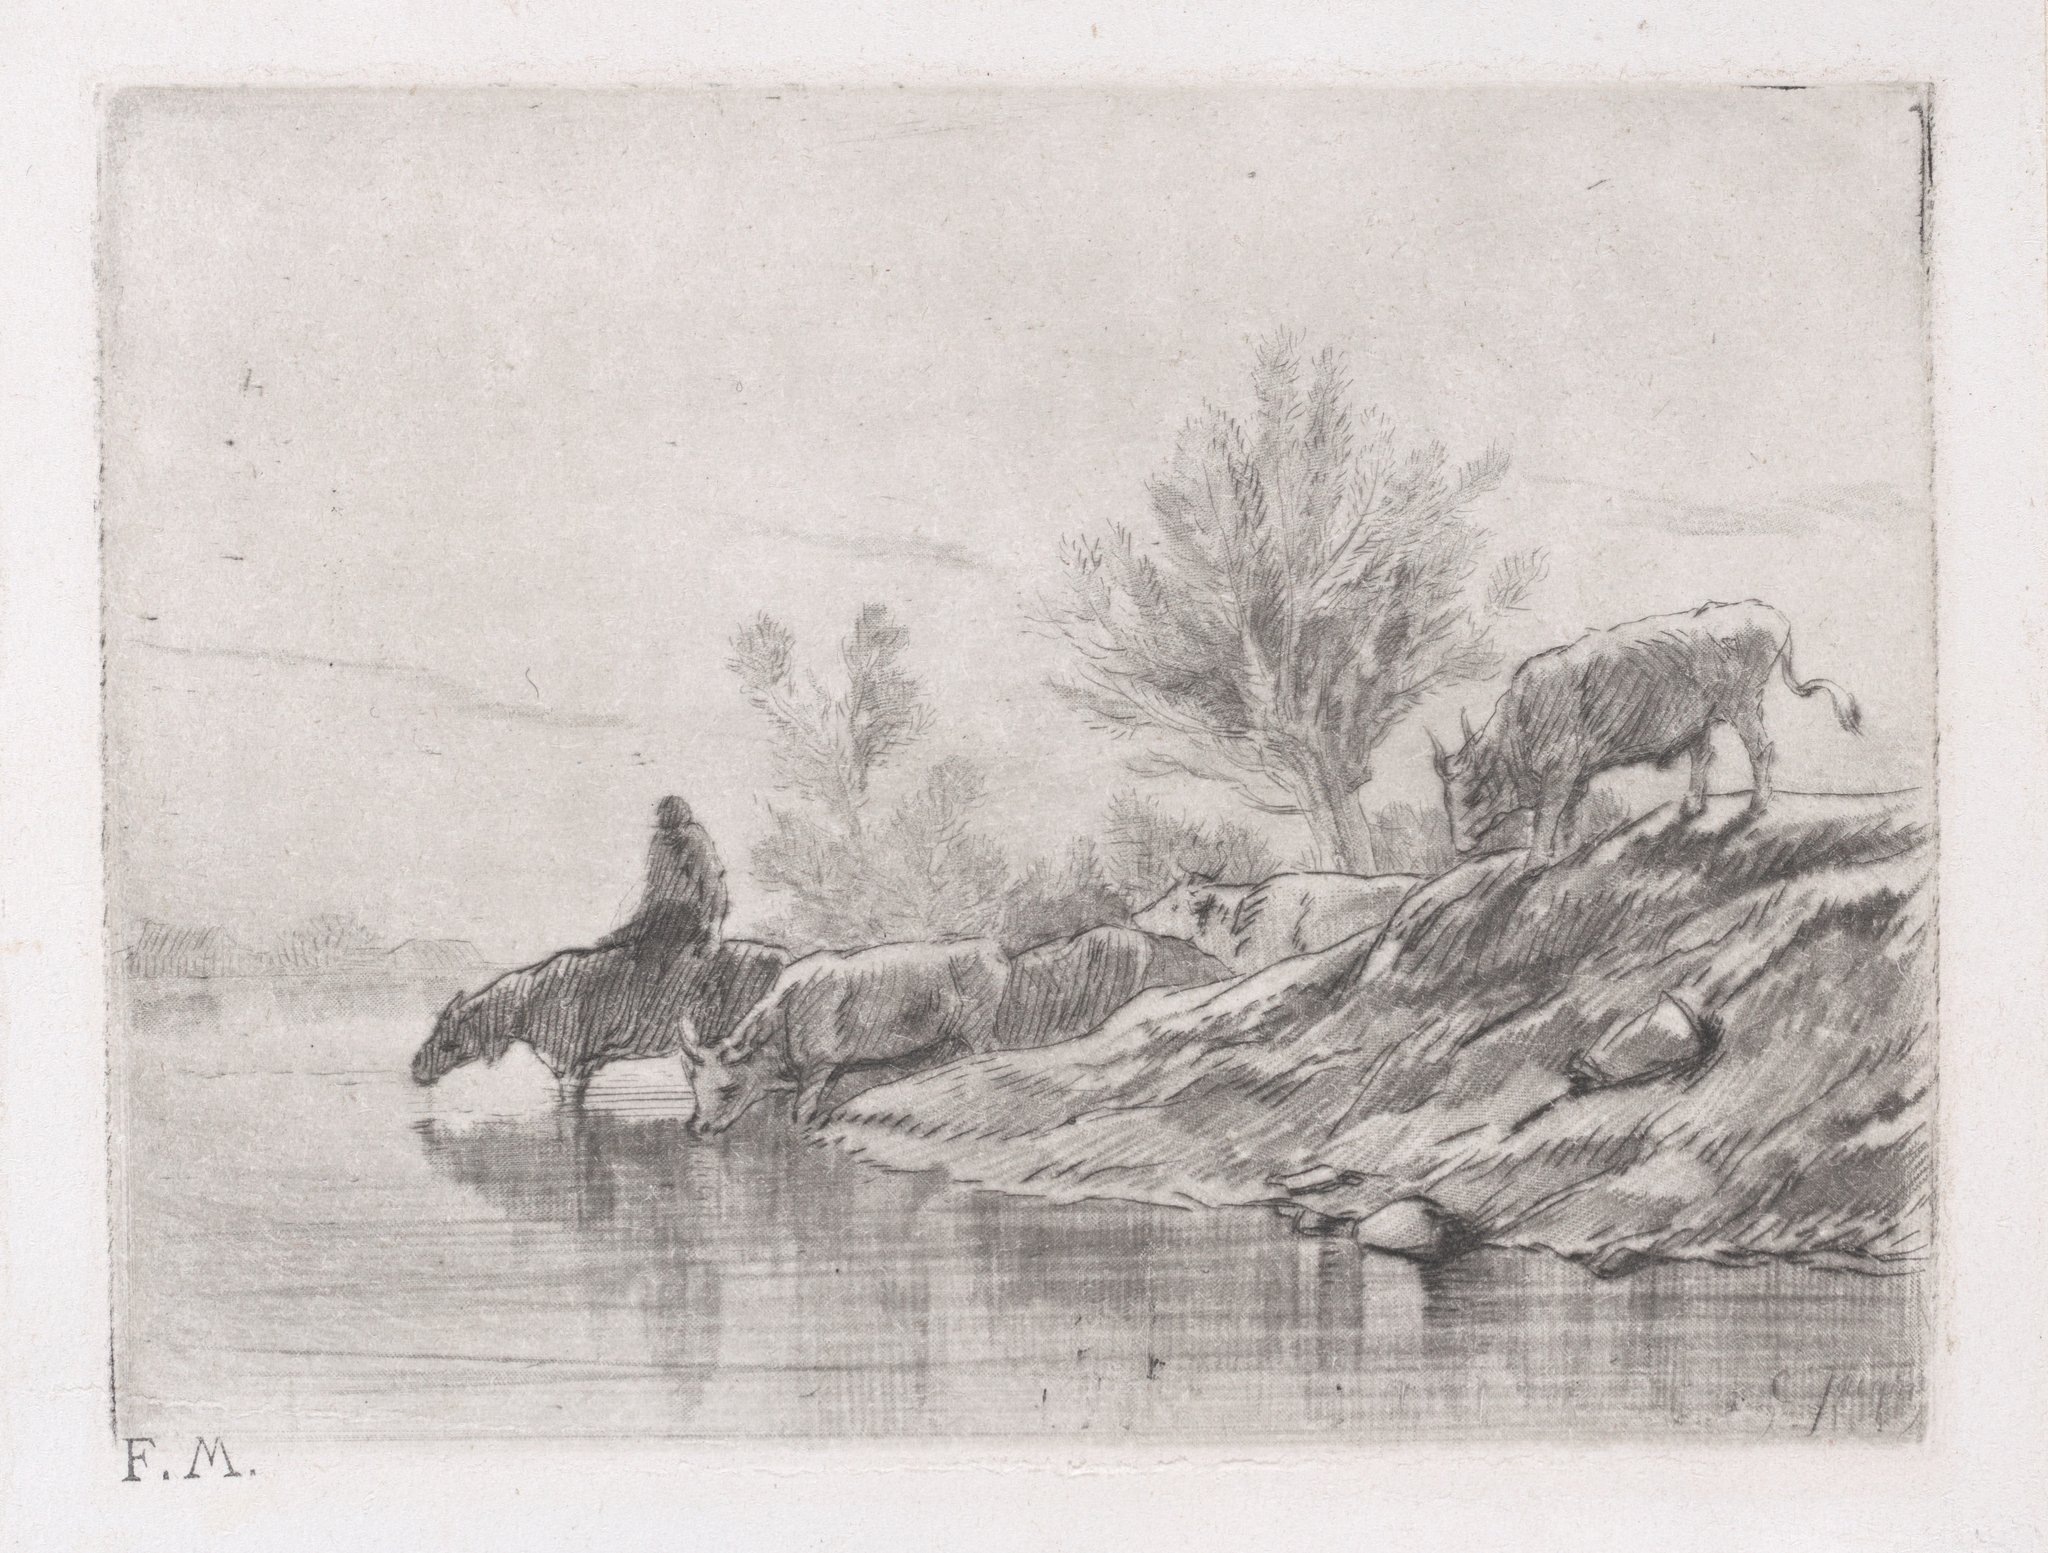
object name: print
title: Landscape with Horses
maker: charles émile jacque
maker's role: artist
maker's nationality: french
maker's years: 1813-1894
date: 1848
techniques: drypoint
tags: cows,horses